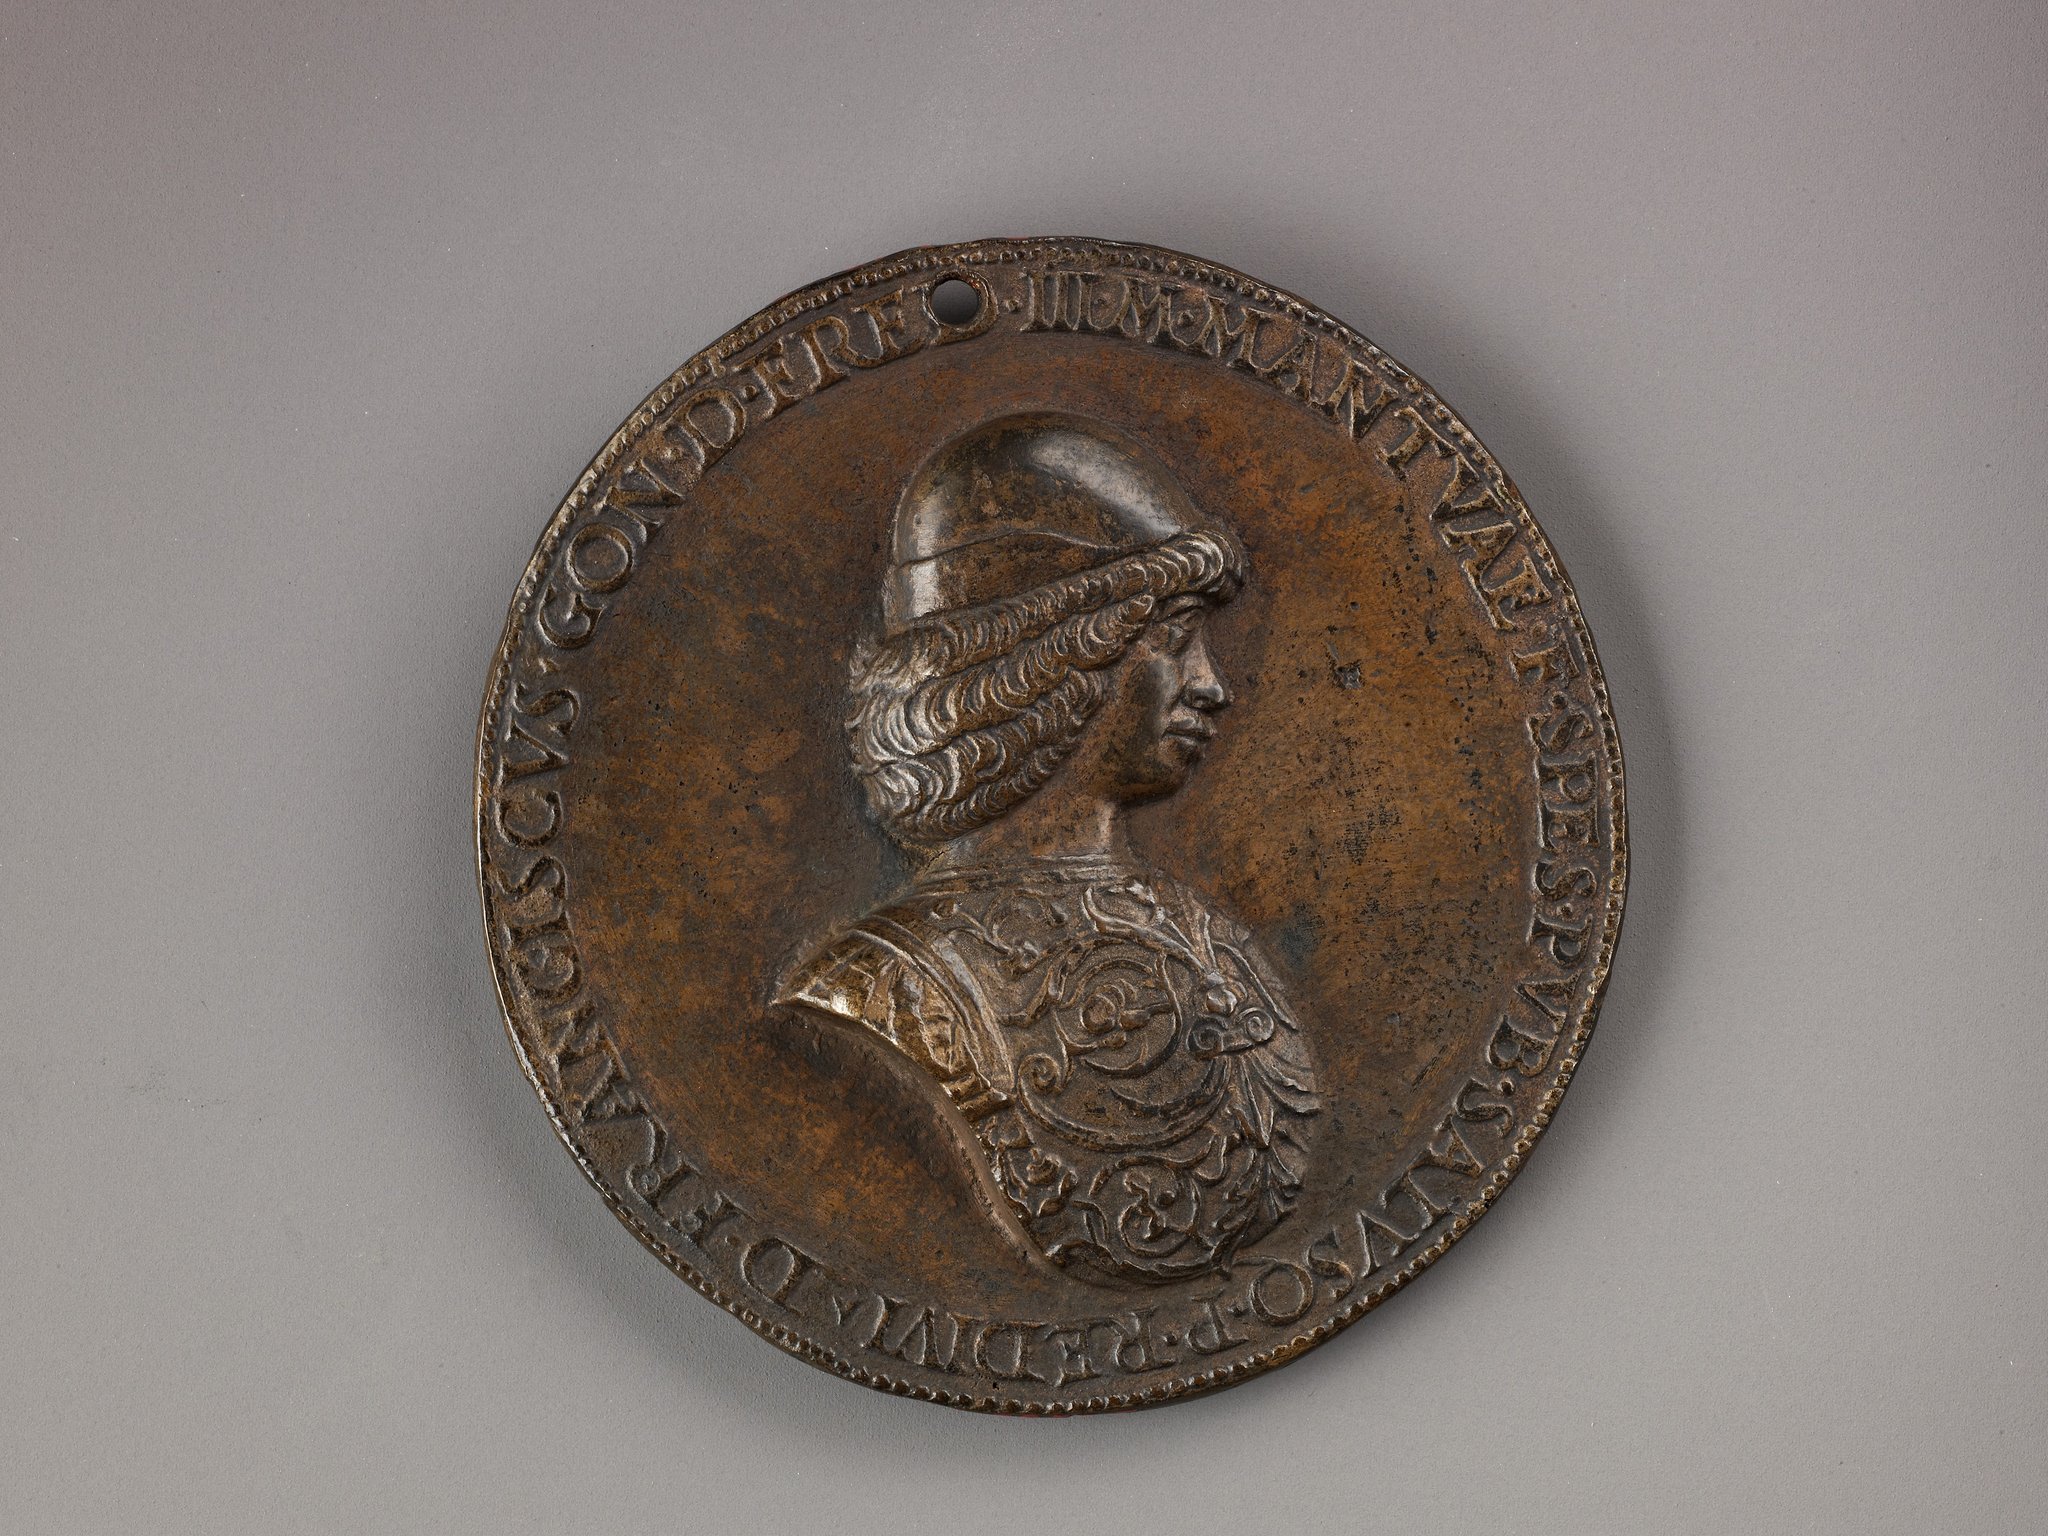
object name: medal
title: Medal: Francesco II Gonzaga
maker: bartolommeo melioli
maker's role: artist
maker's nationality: italian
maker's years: 1448-1514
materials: bronze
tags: men,portraits,profiles,women